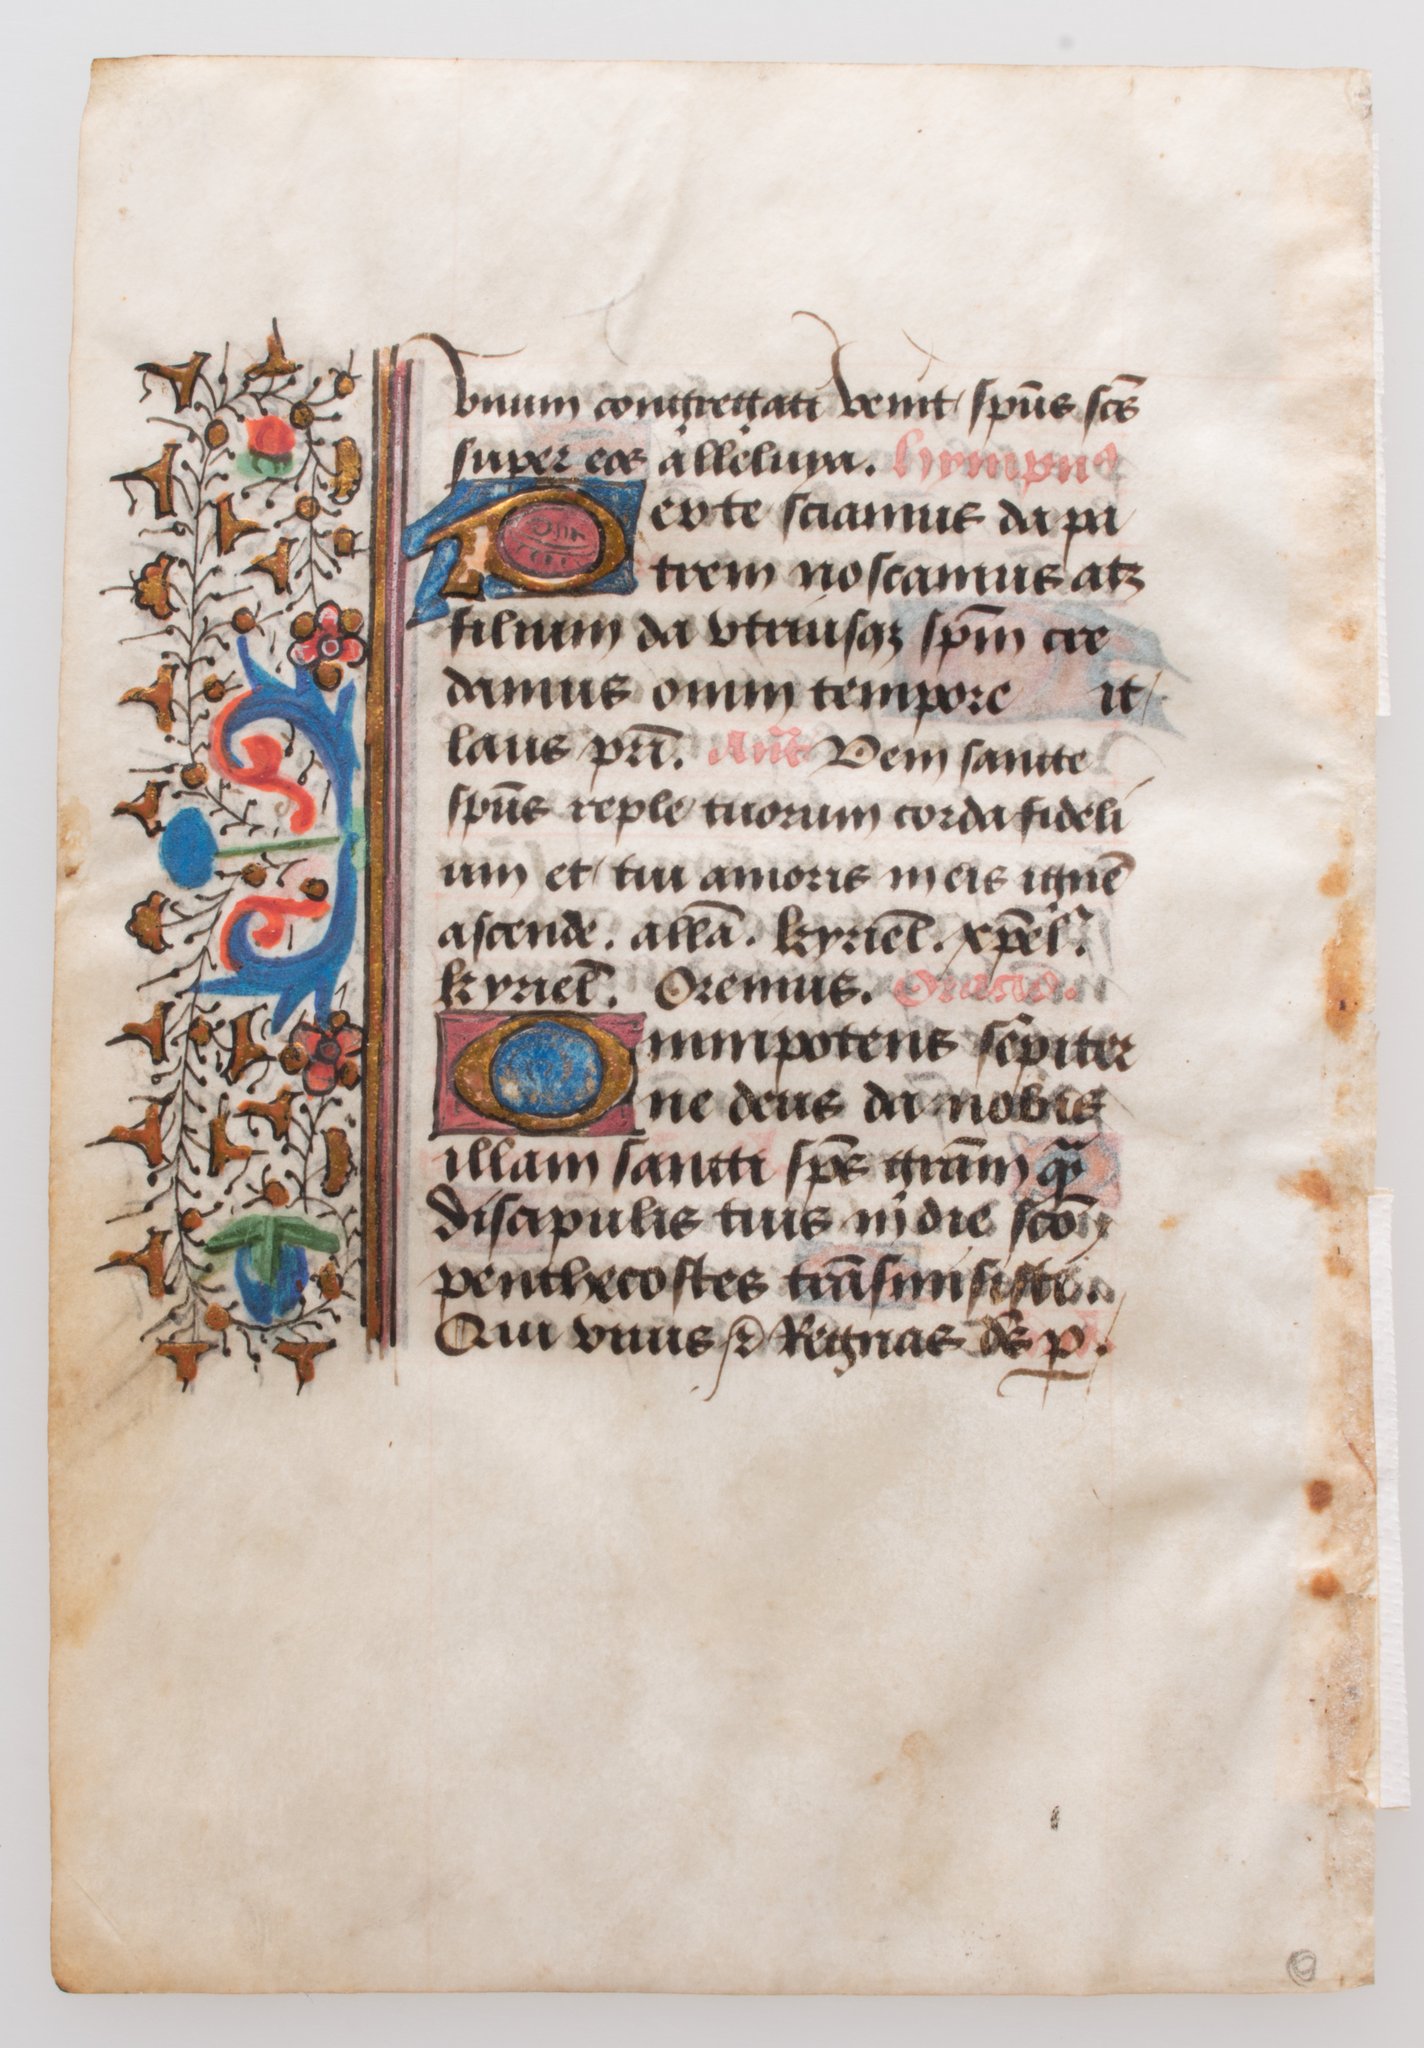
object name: book of hour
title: Manuscript Leaf, from a Book of Hours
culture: french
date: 1401-1500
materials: gold leaf, parchment, paint